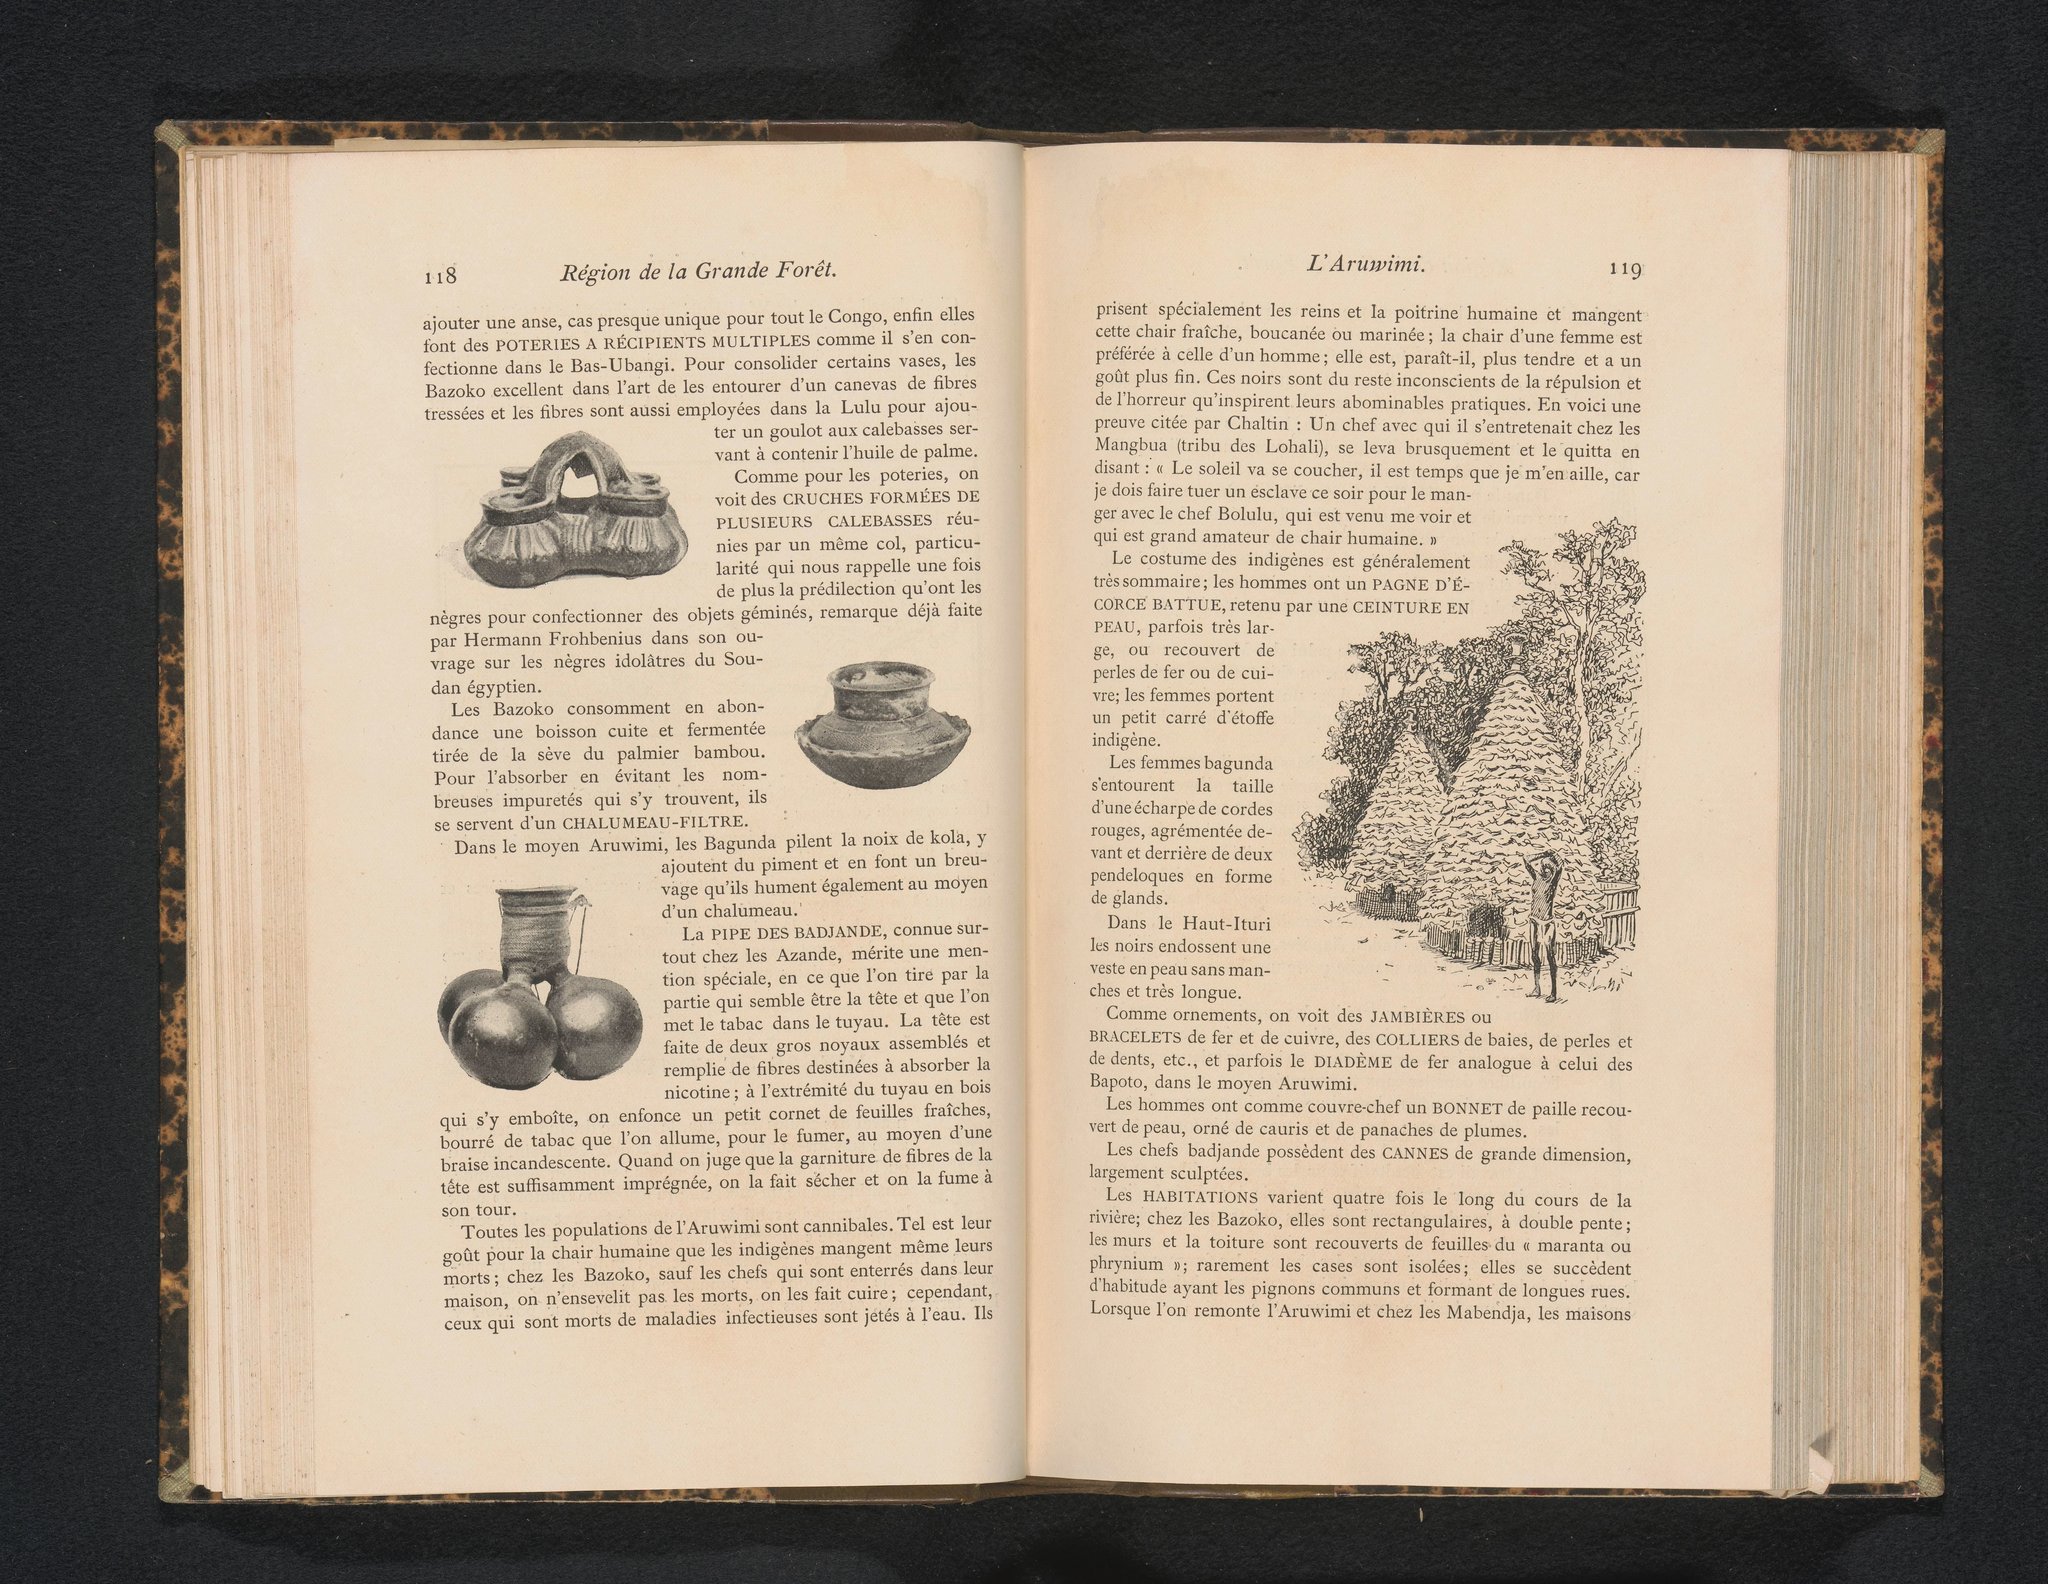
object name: photomechanical print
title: Drie kannen van de Bazoko in Congo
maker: Anonymous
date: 1887-1892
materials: paper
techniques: autotype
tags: historical persons